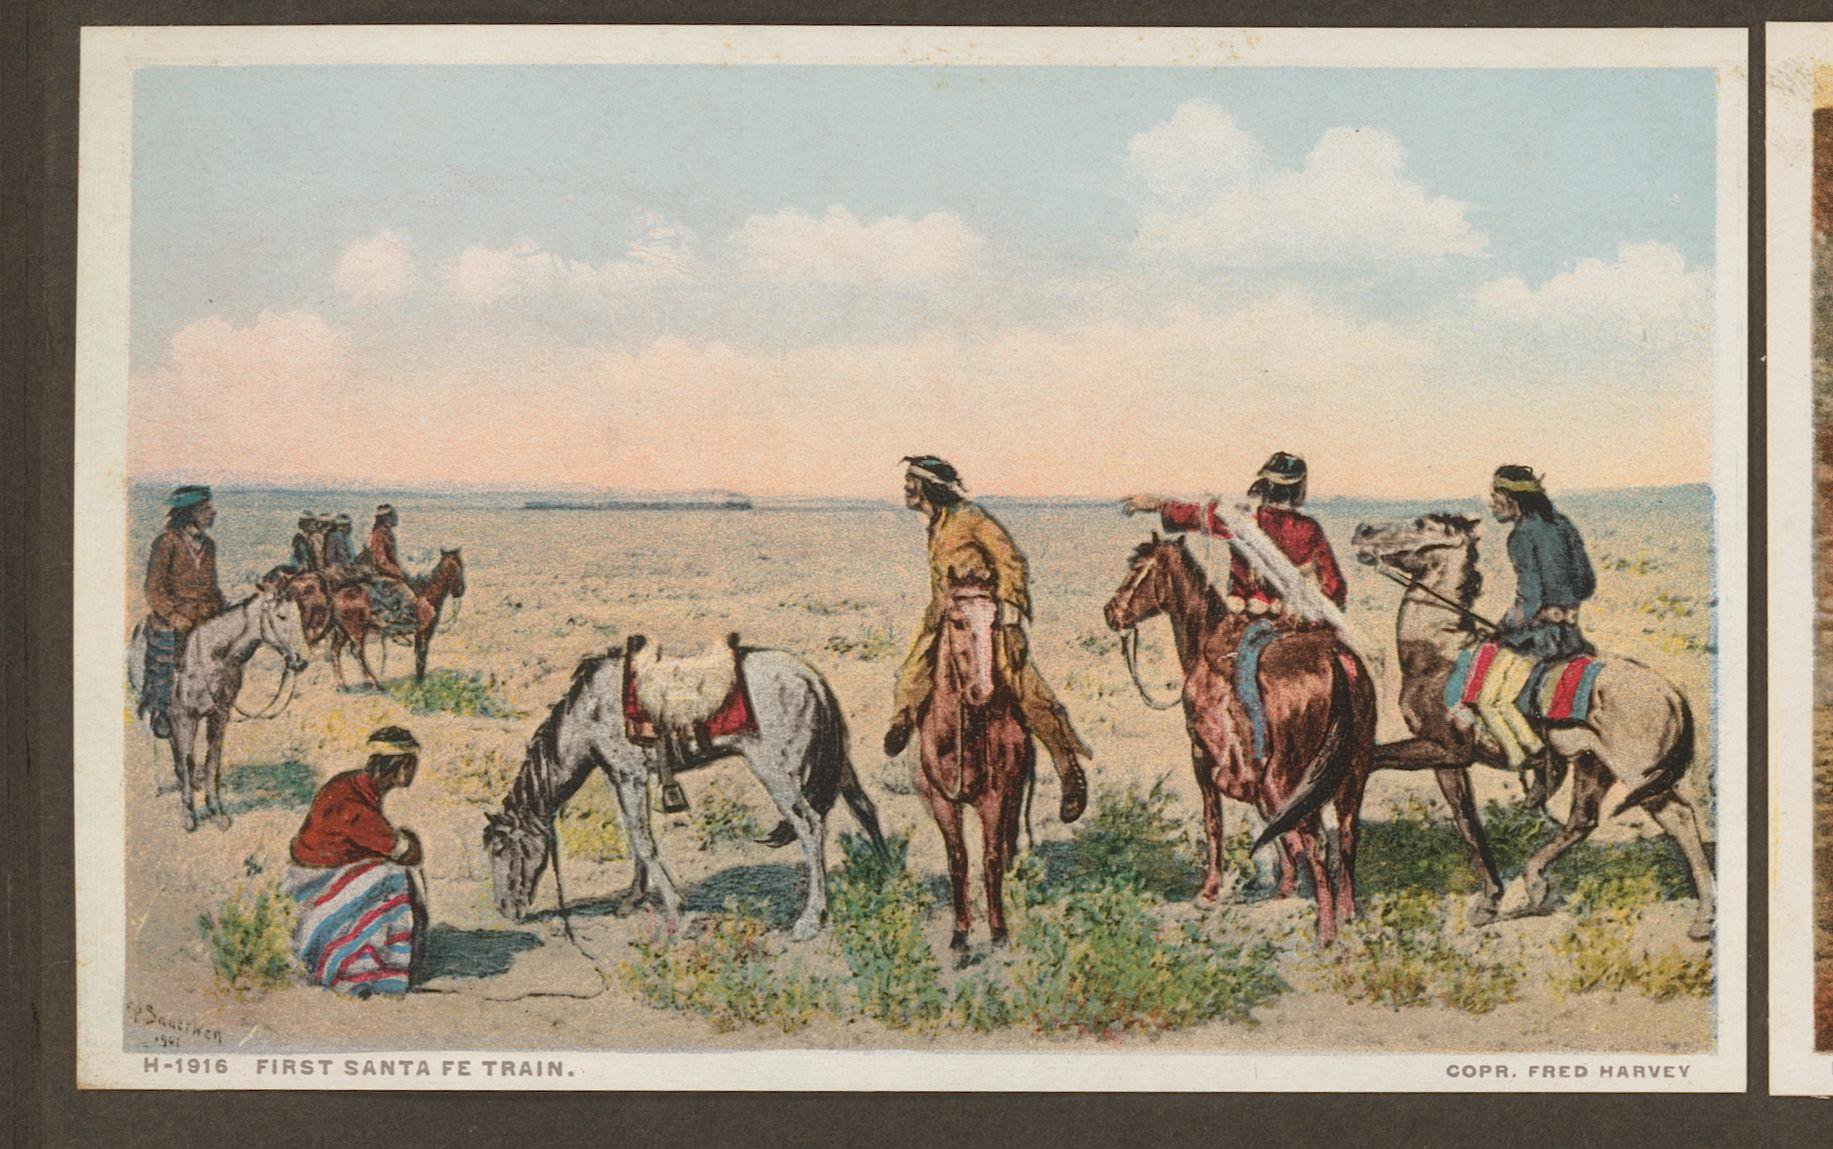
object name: album leaf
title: The first Santa Fe train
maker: Anonymous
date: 1928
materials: paper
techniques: lithograph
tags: indigenous peoples of north america, horse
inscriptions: number: ‘H-1916’